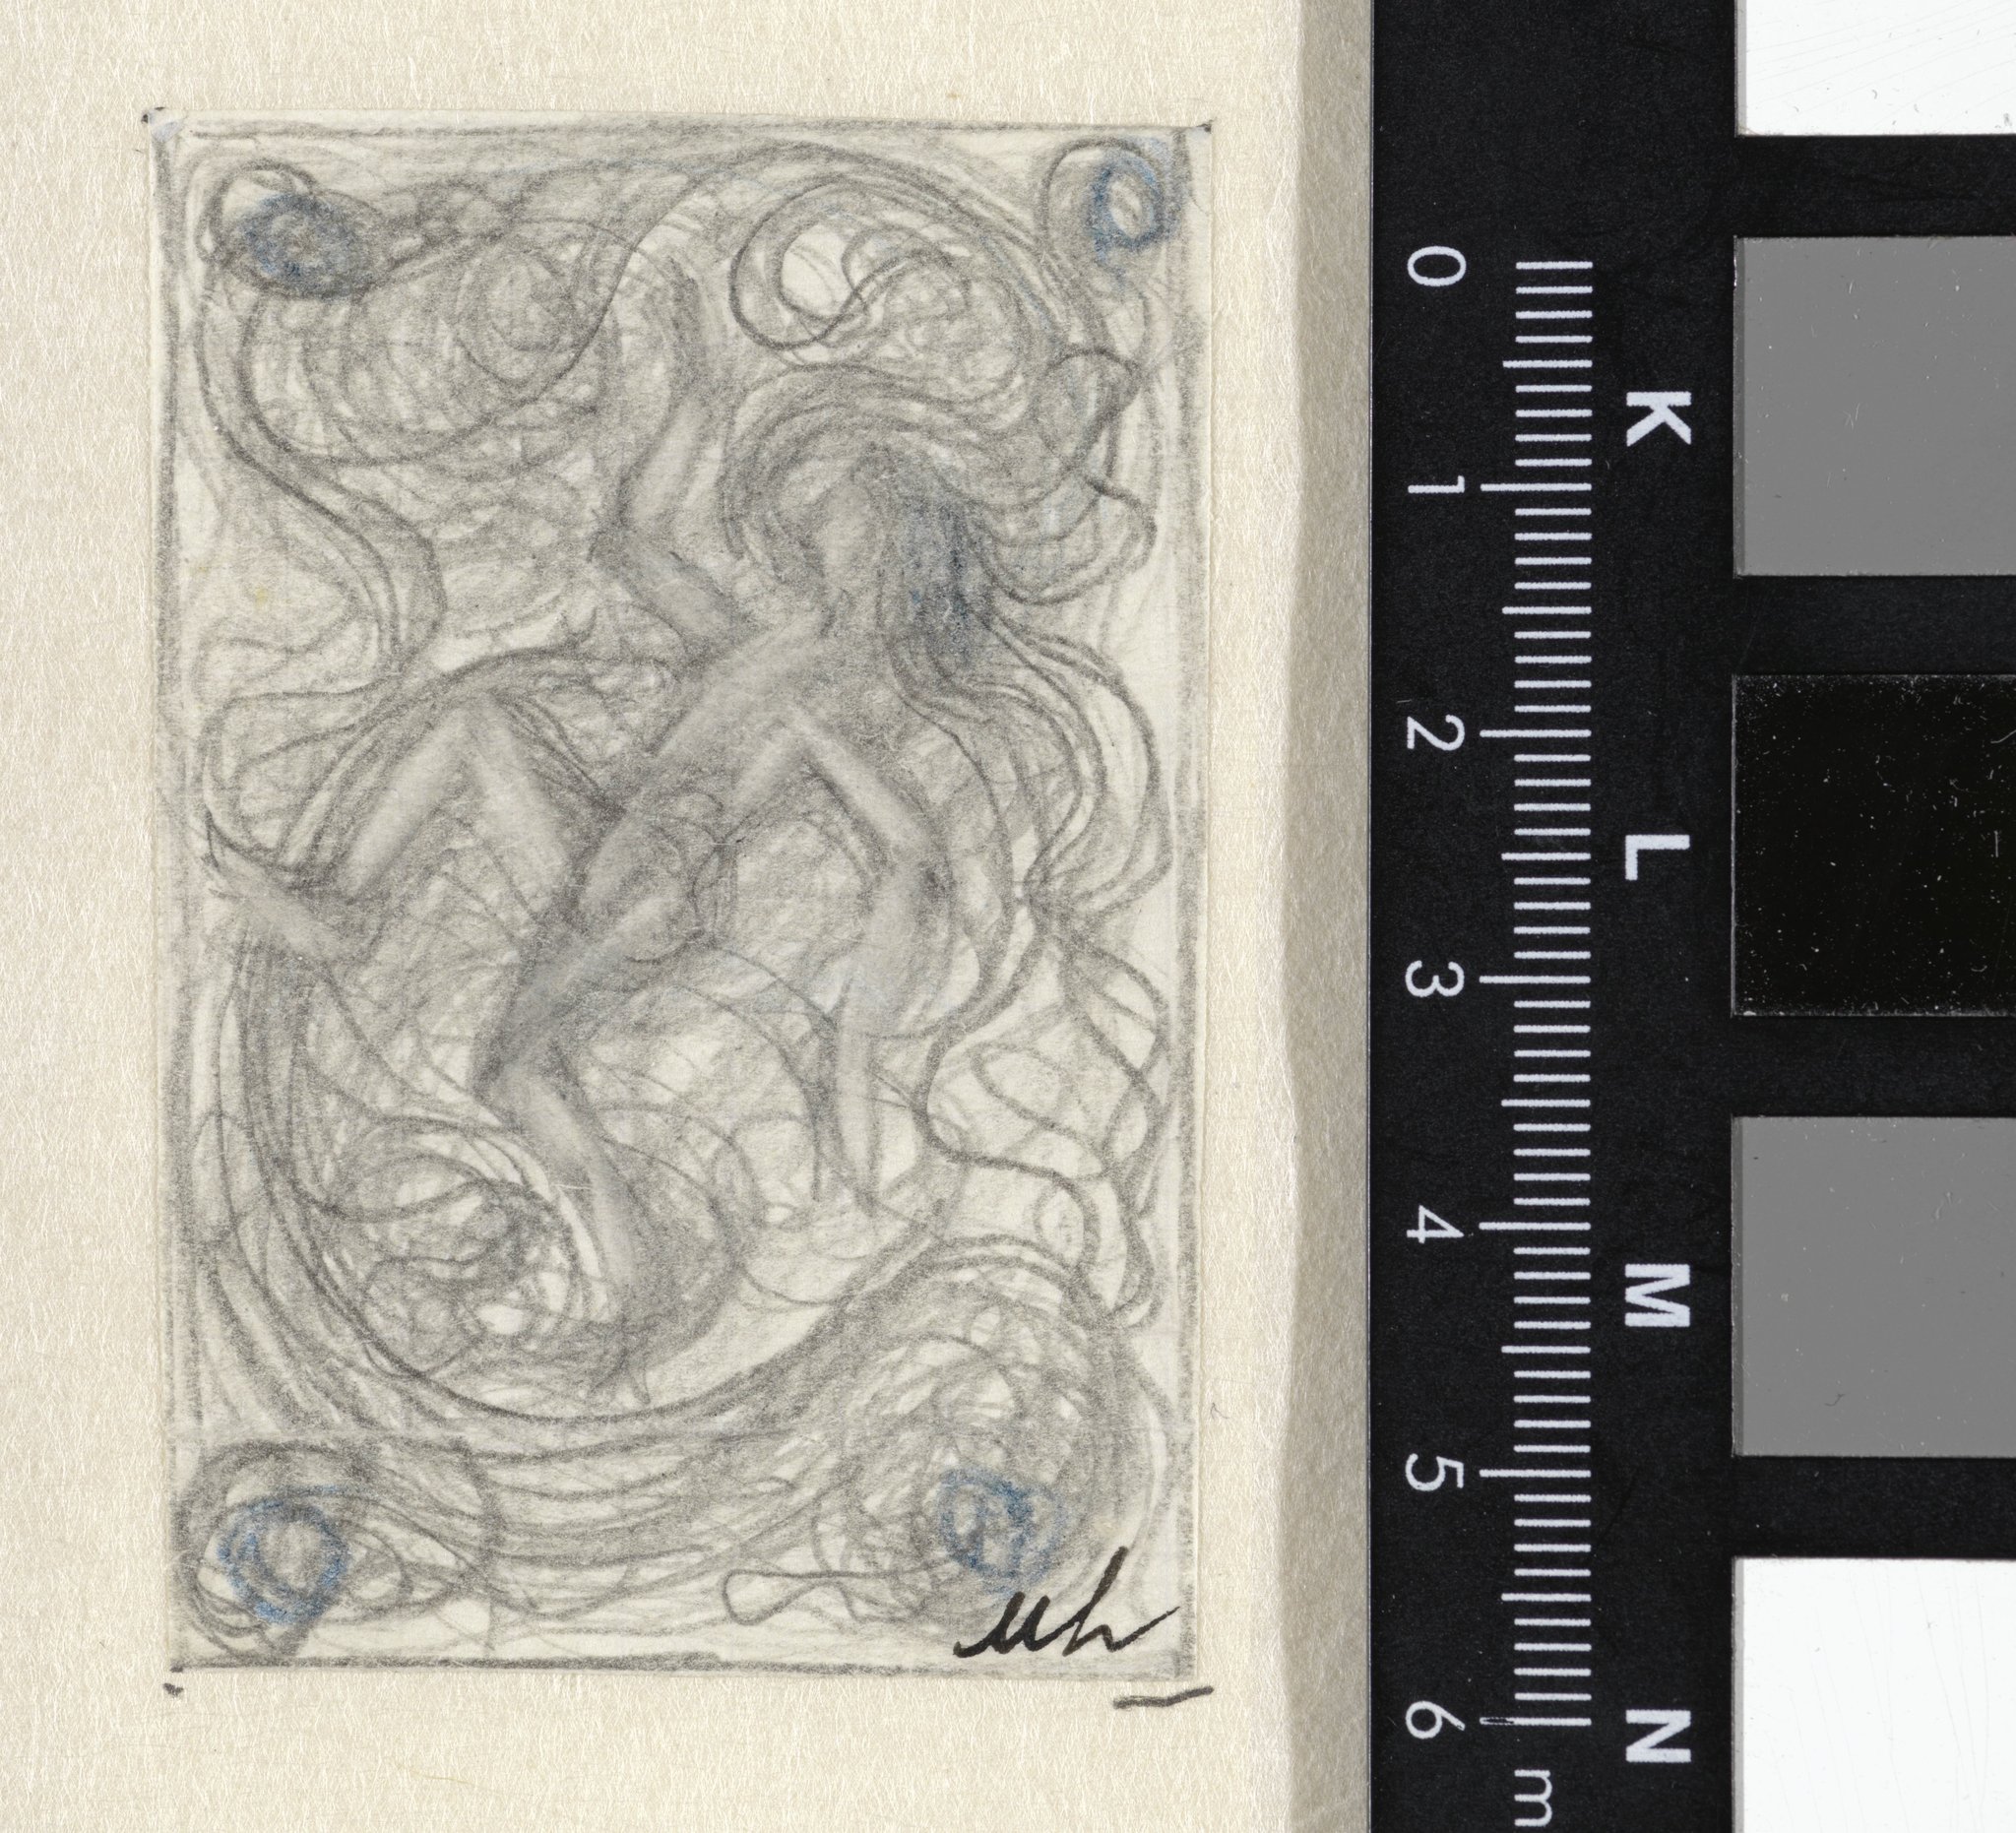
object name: drawing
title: Ontwerp voor een sieraad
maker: mathieu lauweriks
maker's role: designer, draughtsman, print maker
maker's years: 1864-1932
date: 1874-1932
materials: paper, pencil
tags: ornaments, jewels